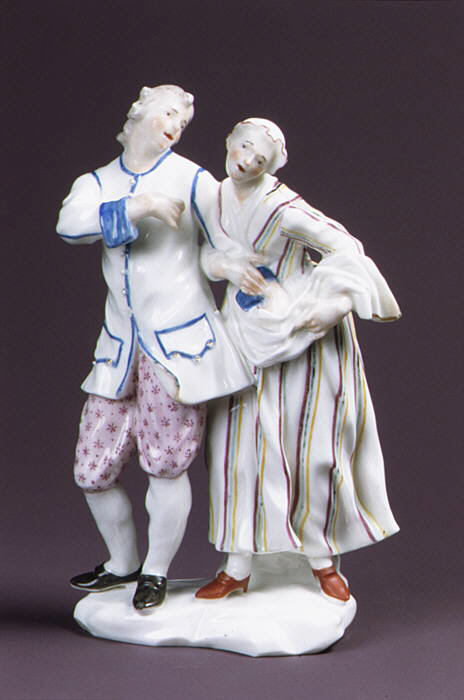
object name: group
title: Lovers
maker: capodimonte porcelain manufactory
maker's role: manufactory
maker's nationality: italian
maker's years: 1740-1759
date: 1750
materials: soft paste porcelain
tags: men,lovers,women